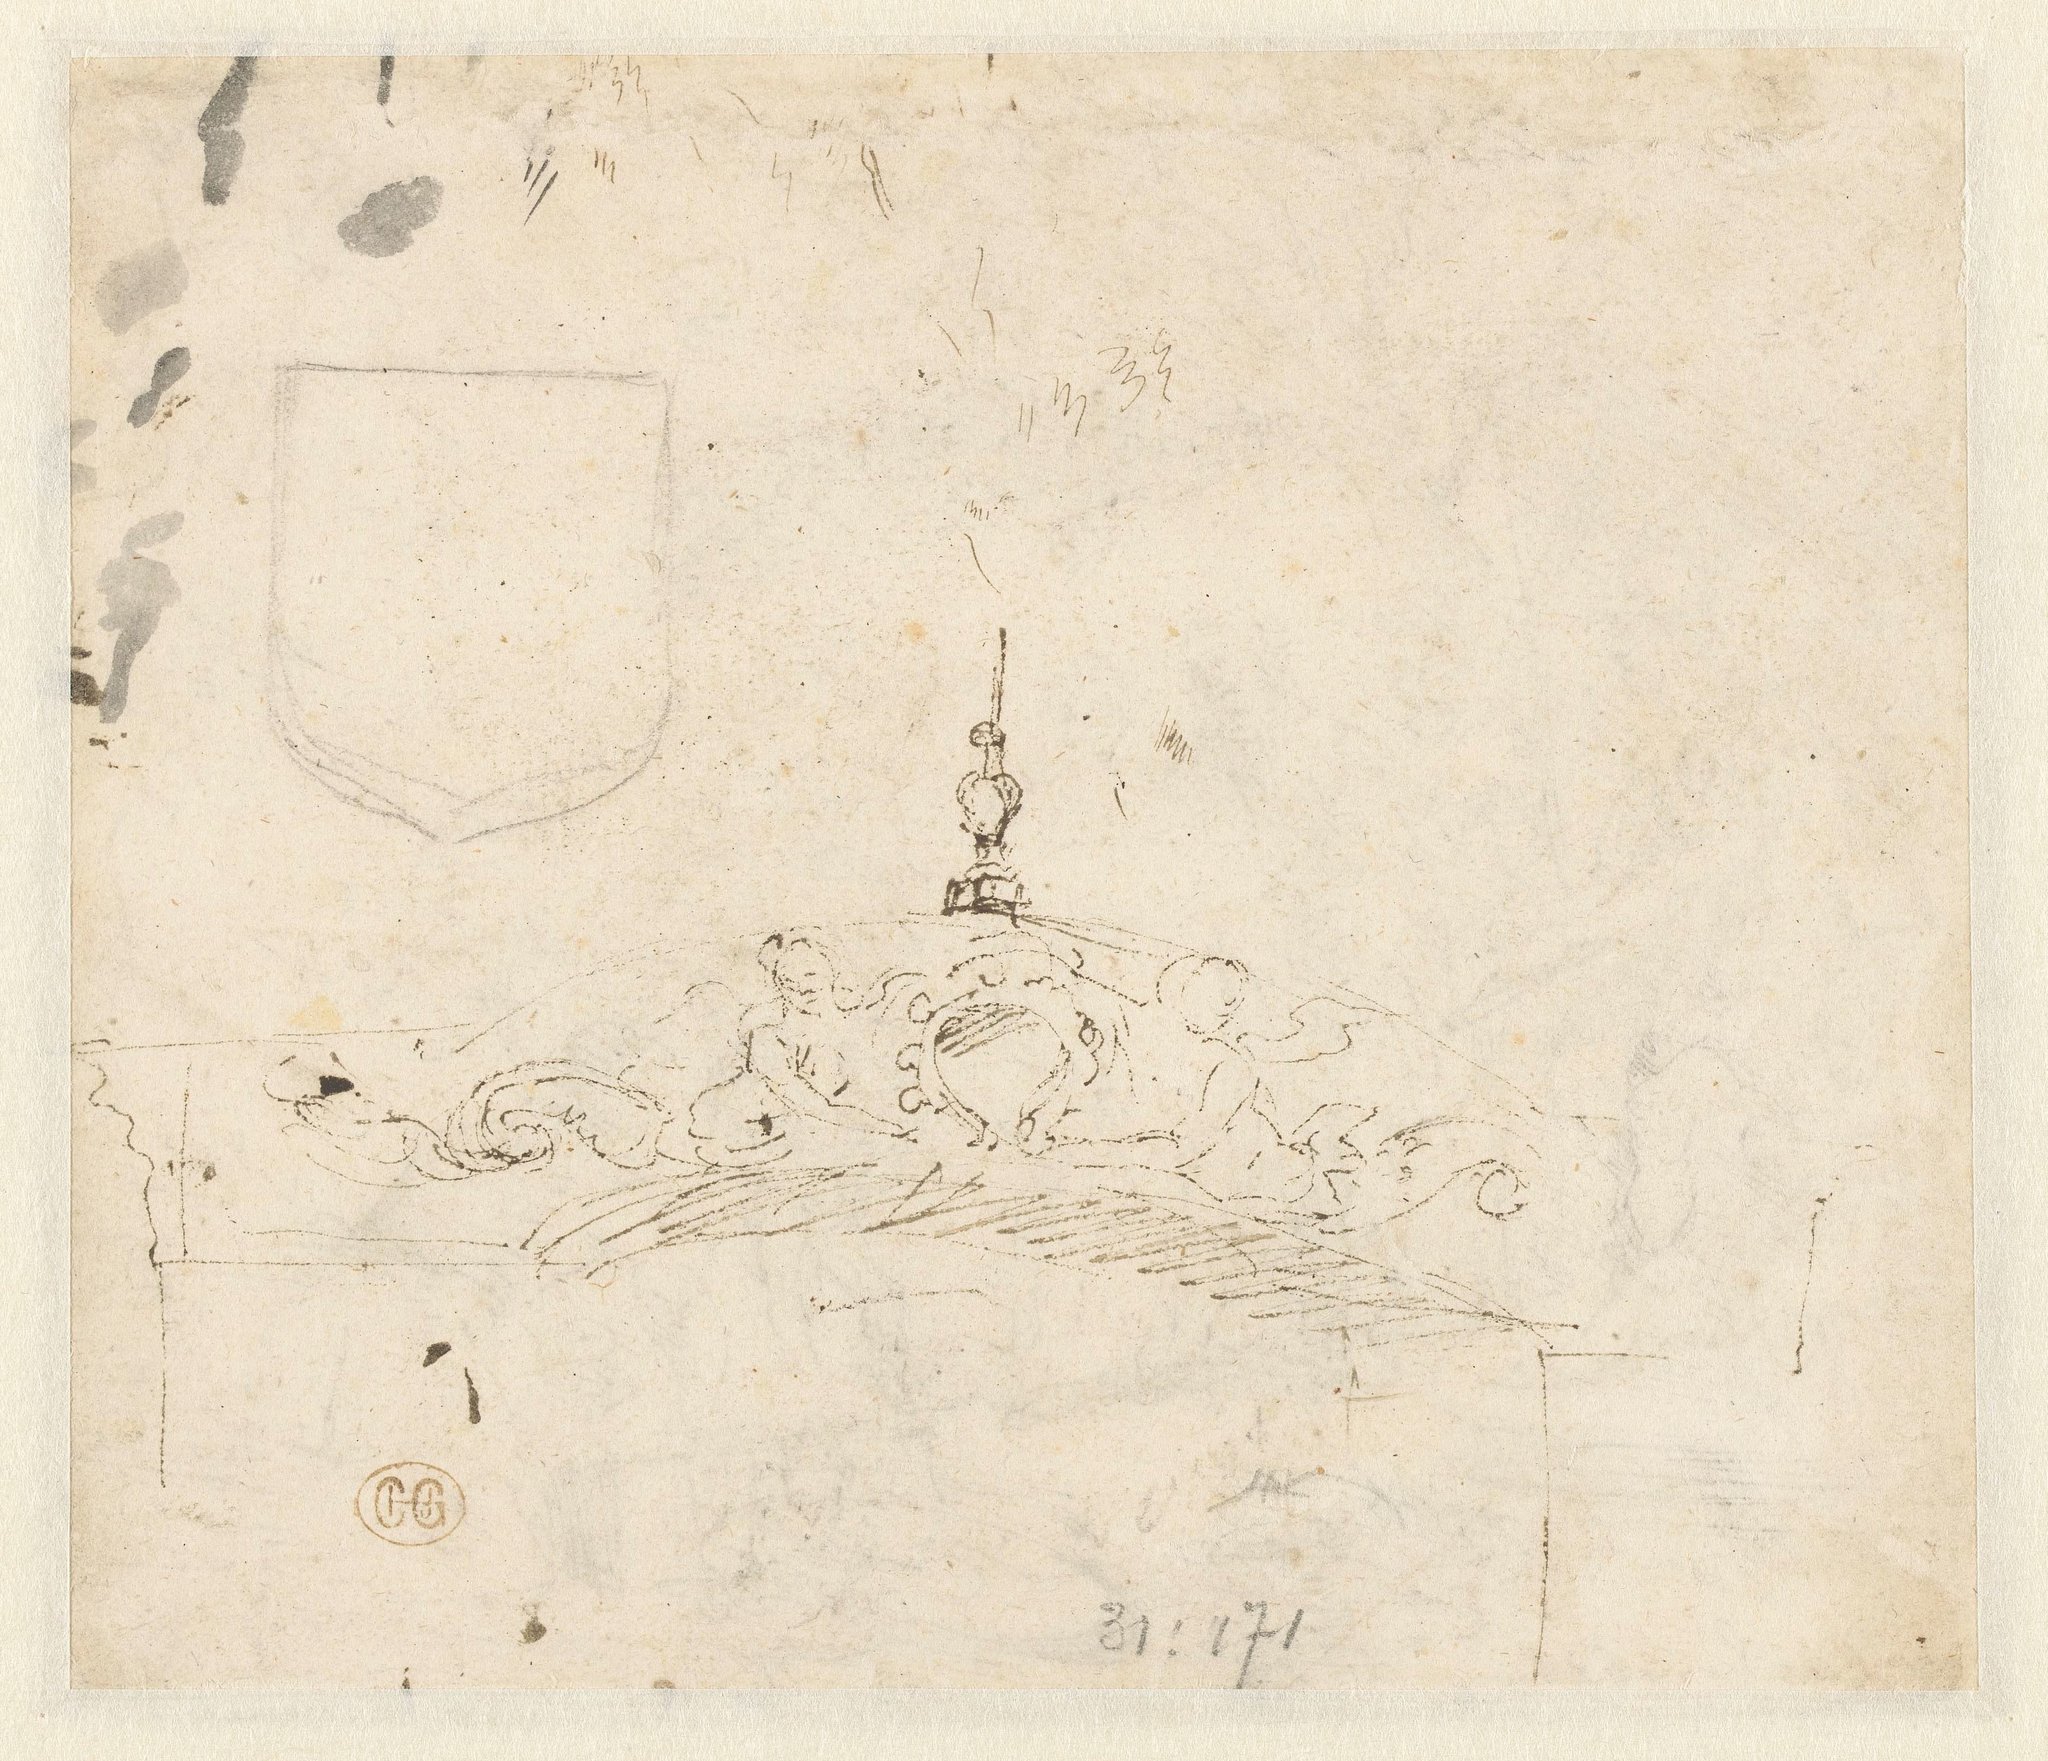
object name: drawing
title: Ornamentale boog met twee zeewezens met een wapenschild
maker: matthys van den bergh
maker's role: draughtsman, print maker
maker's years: 1617-1687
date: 1656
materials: ink, paper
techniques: pen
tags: architectural detail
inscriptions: date